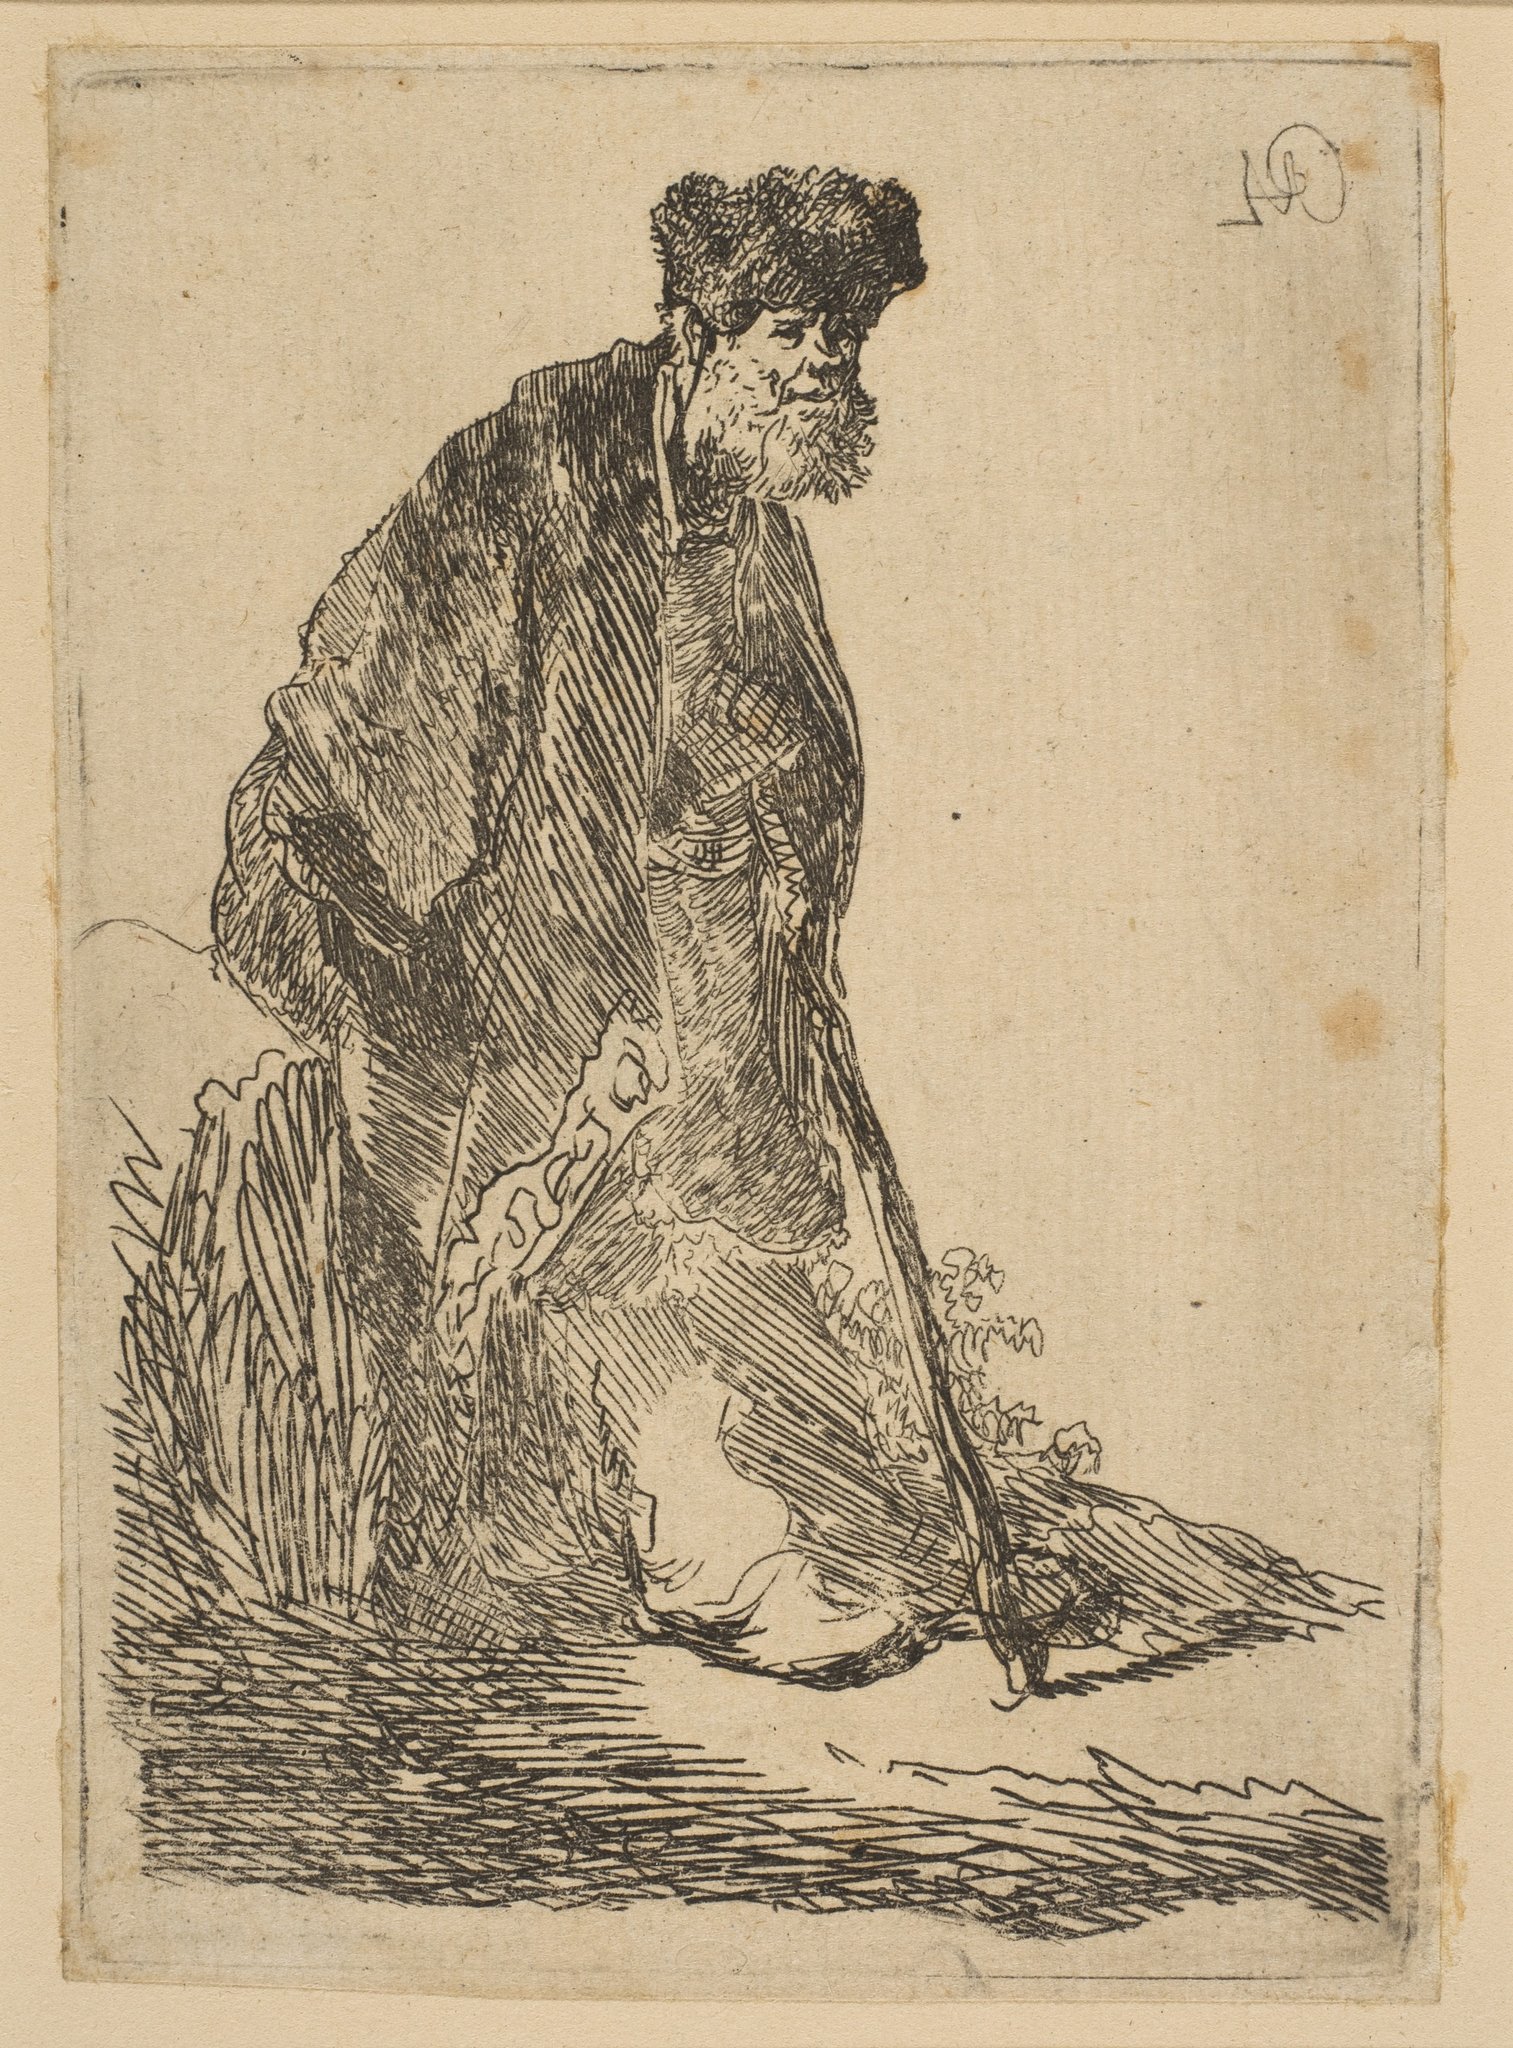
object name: print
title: Man in a Cloak and Fur Cap, Leaning against a Bank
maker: rembrandt van rijn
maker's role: artist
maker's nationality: dutch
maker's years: 1606-1669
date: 1630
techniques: etching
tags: men